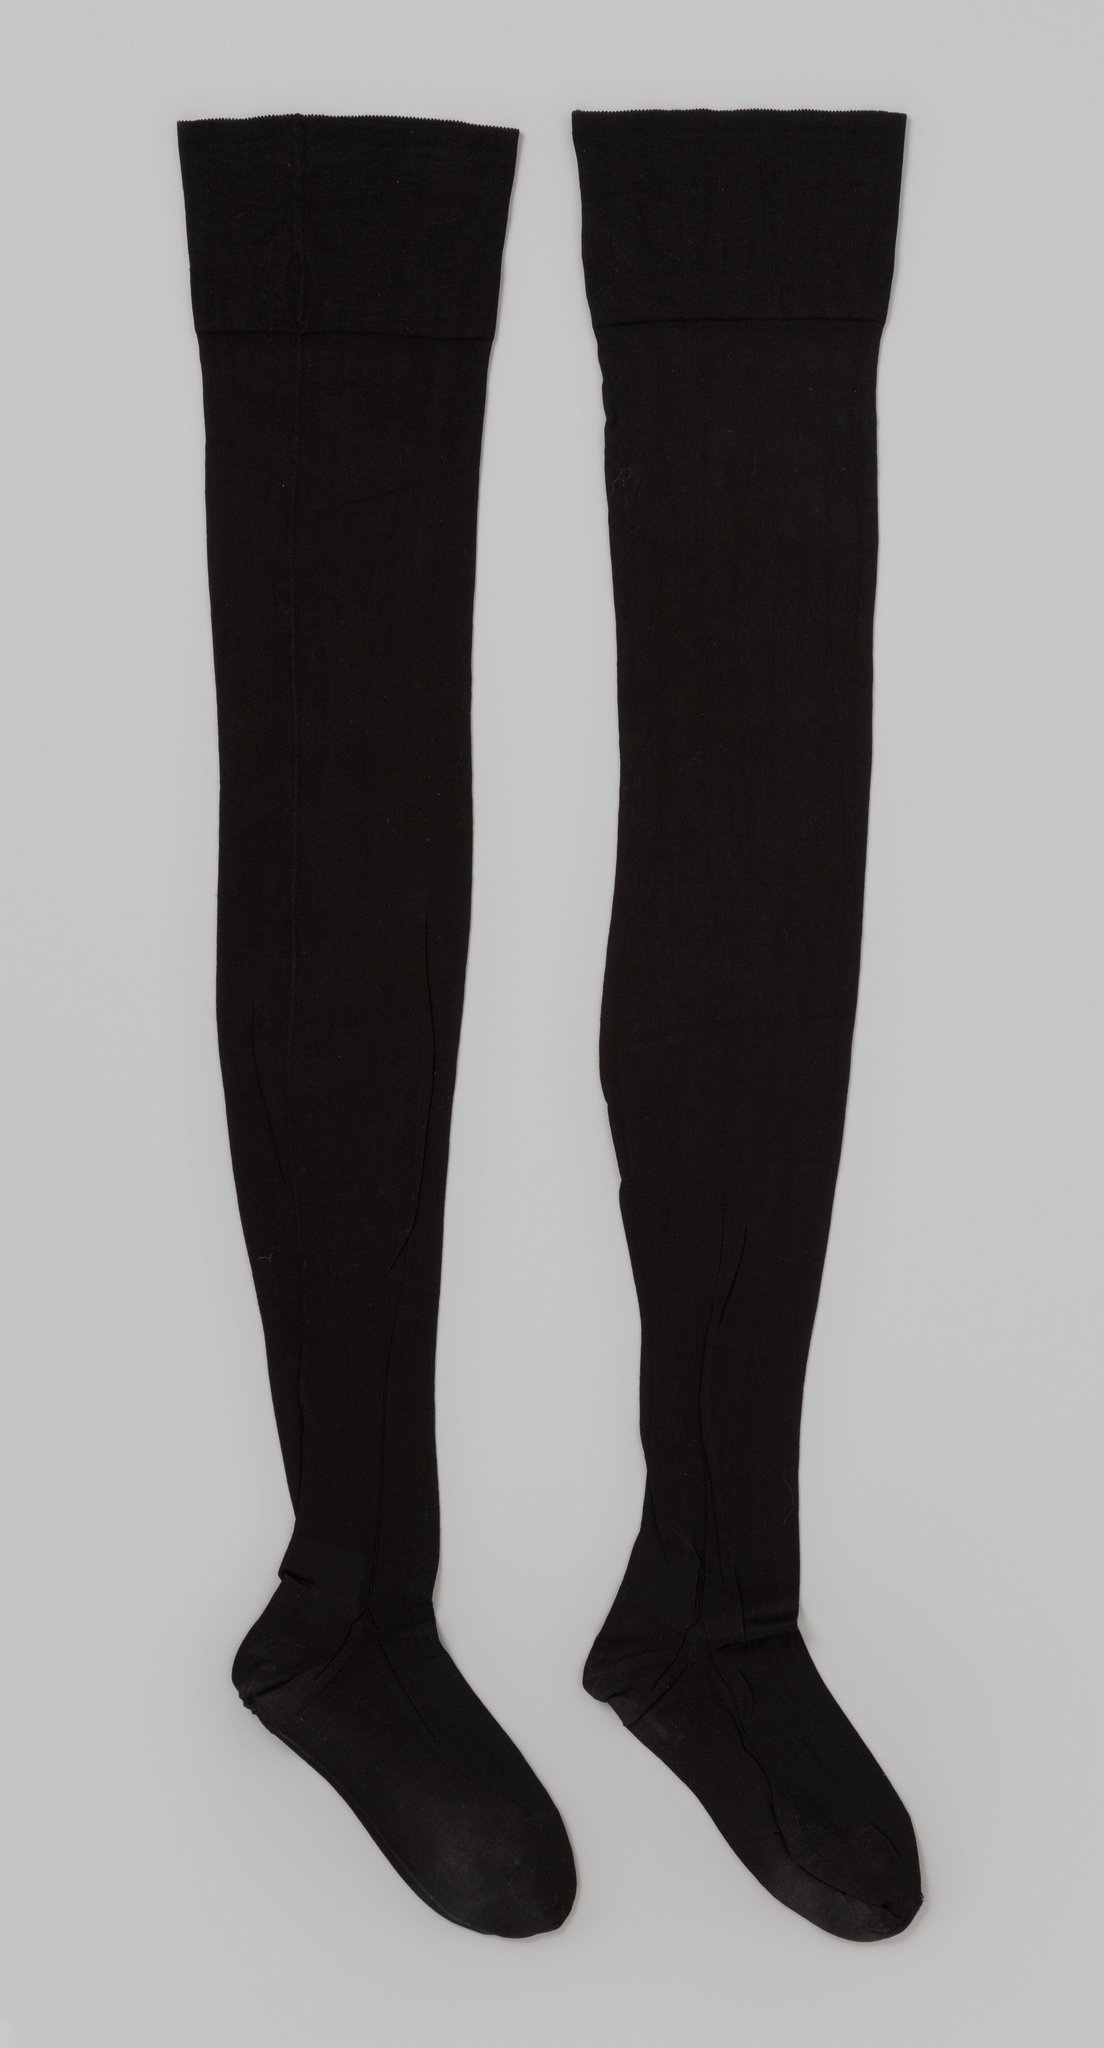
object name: stocking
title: Kous van effen zwarte zijden tricot met smalle verticale lijn op de klink en brede boord met kleine kartels langs de rand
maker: Anonymous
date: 1915-1935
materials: silk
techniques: knitting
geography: netherlands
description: Vijf paar zwarte kousen van zijde. Alle verschillend, alle van dikke tricot. Alle met naad en hiel. Brede verschillende boorden; enkele van katoen. Eén paar heeft een enkel-pijl, de klink.